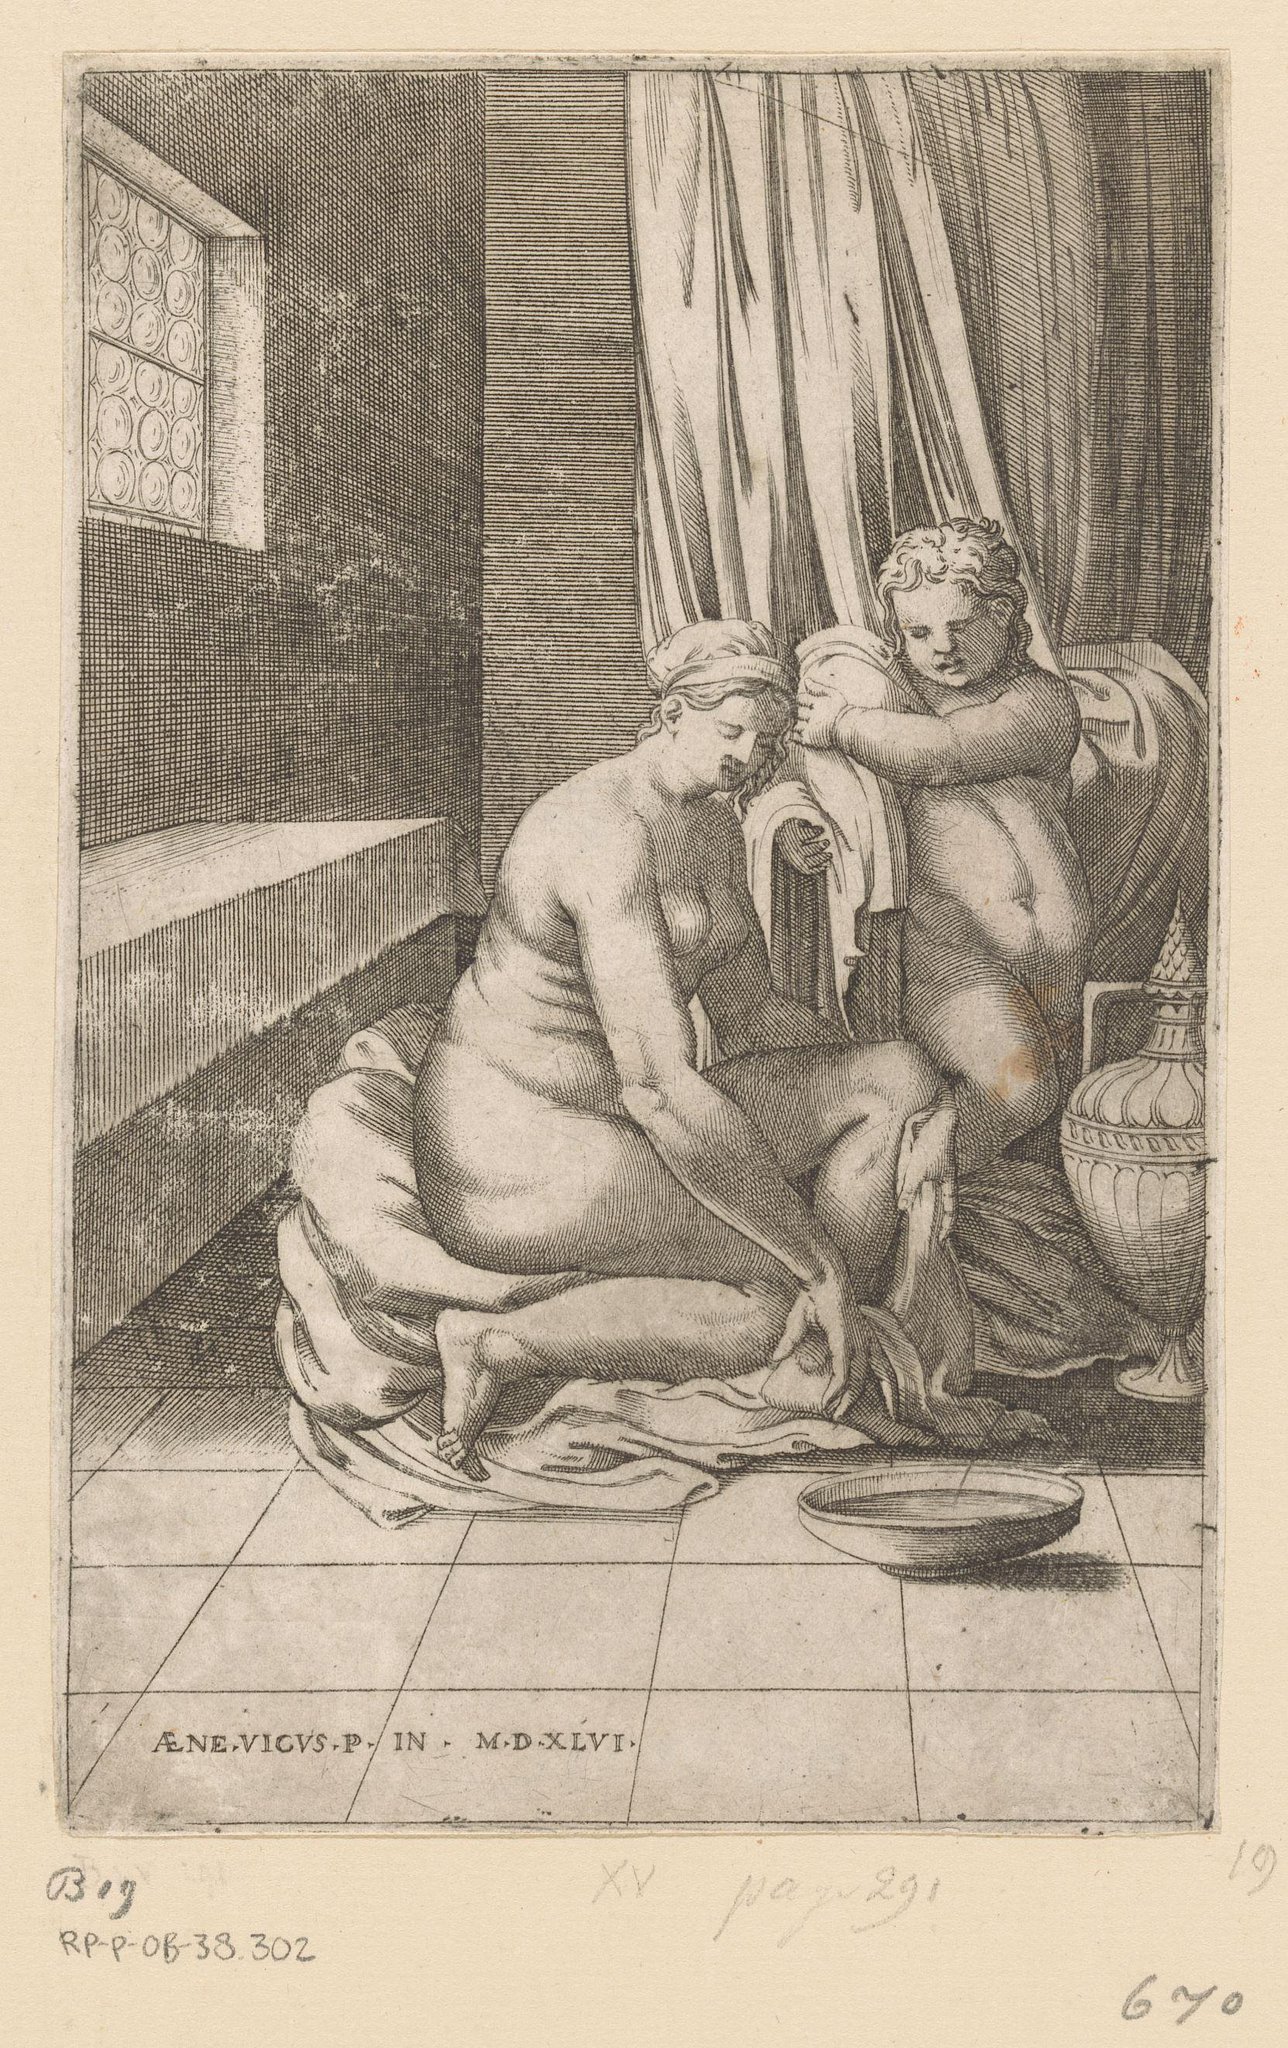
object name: print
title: Toilet van Venus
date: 1546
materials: paper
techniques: engraving, intaglio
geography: italy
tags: toilet of venus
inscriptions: collector's mark: Lugt 240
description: Venus droogt zich af na een bad. Rechts staat Amor.